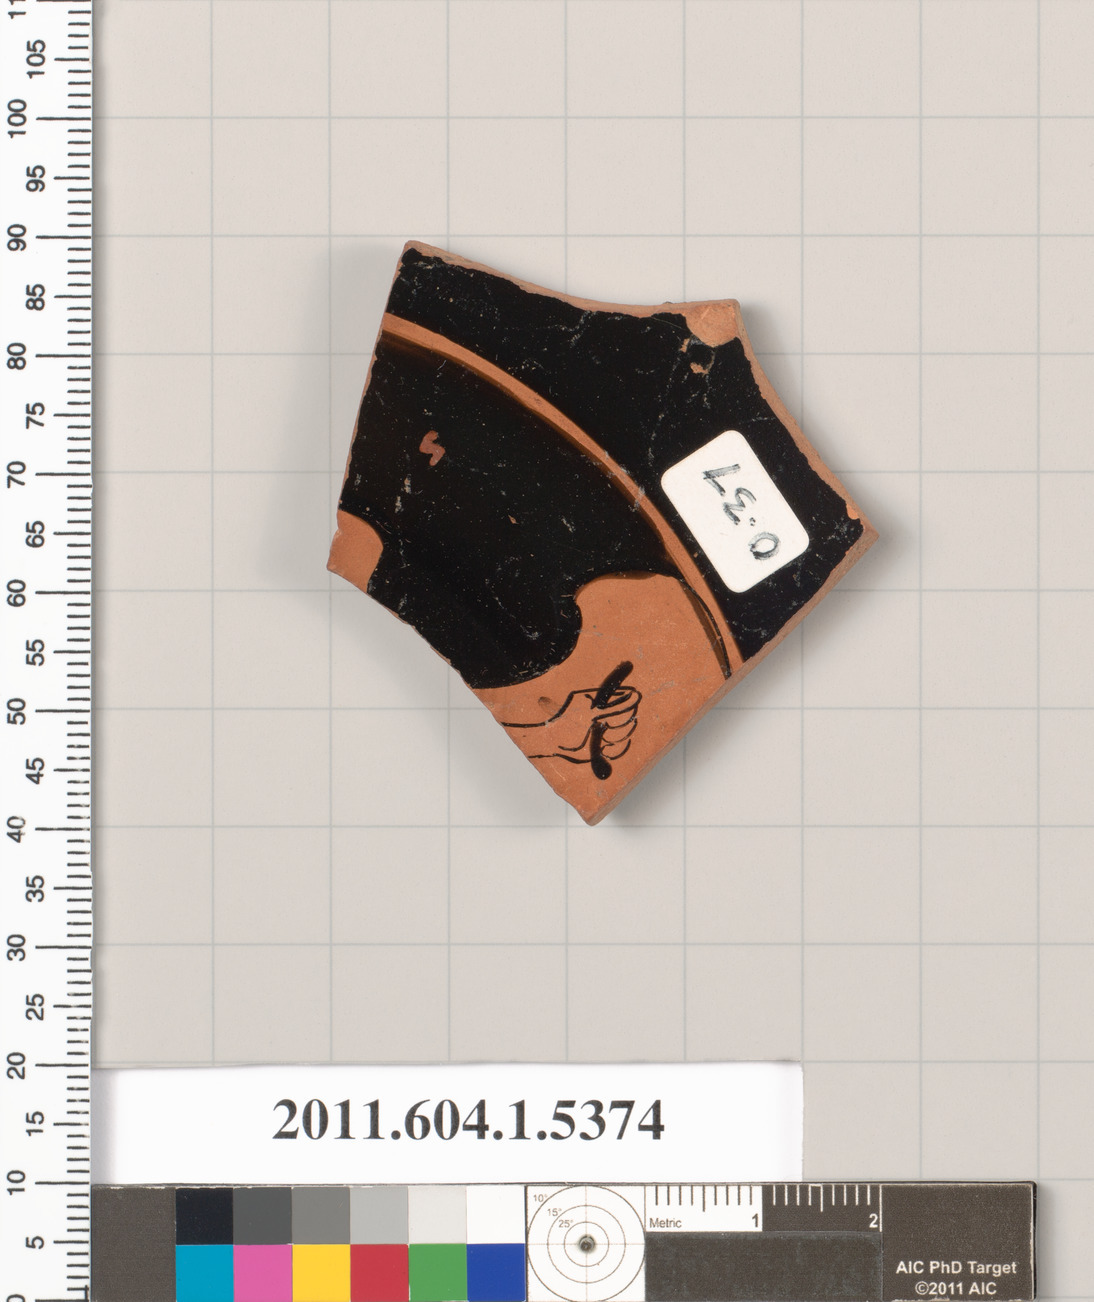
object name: kylix fragment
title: Terracotta fragment of a kylix (drinking cup)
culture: greek, attic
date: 500-480 BCE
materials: terracotta